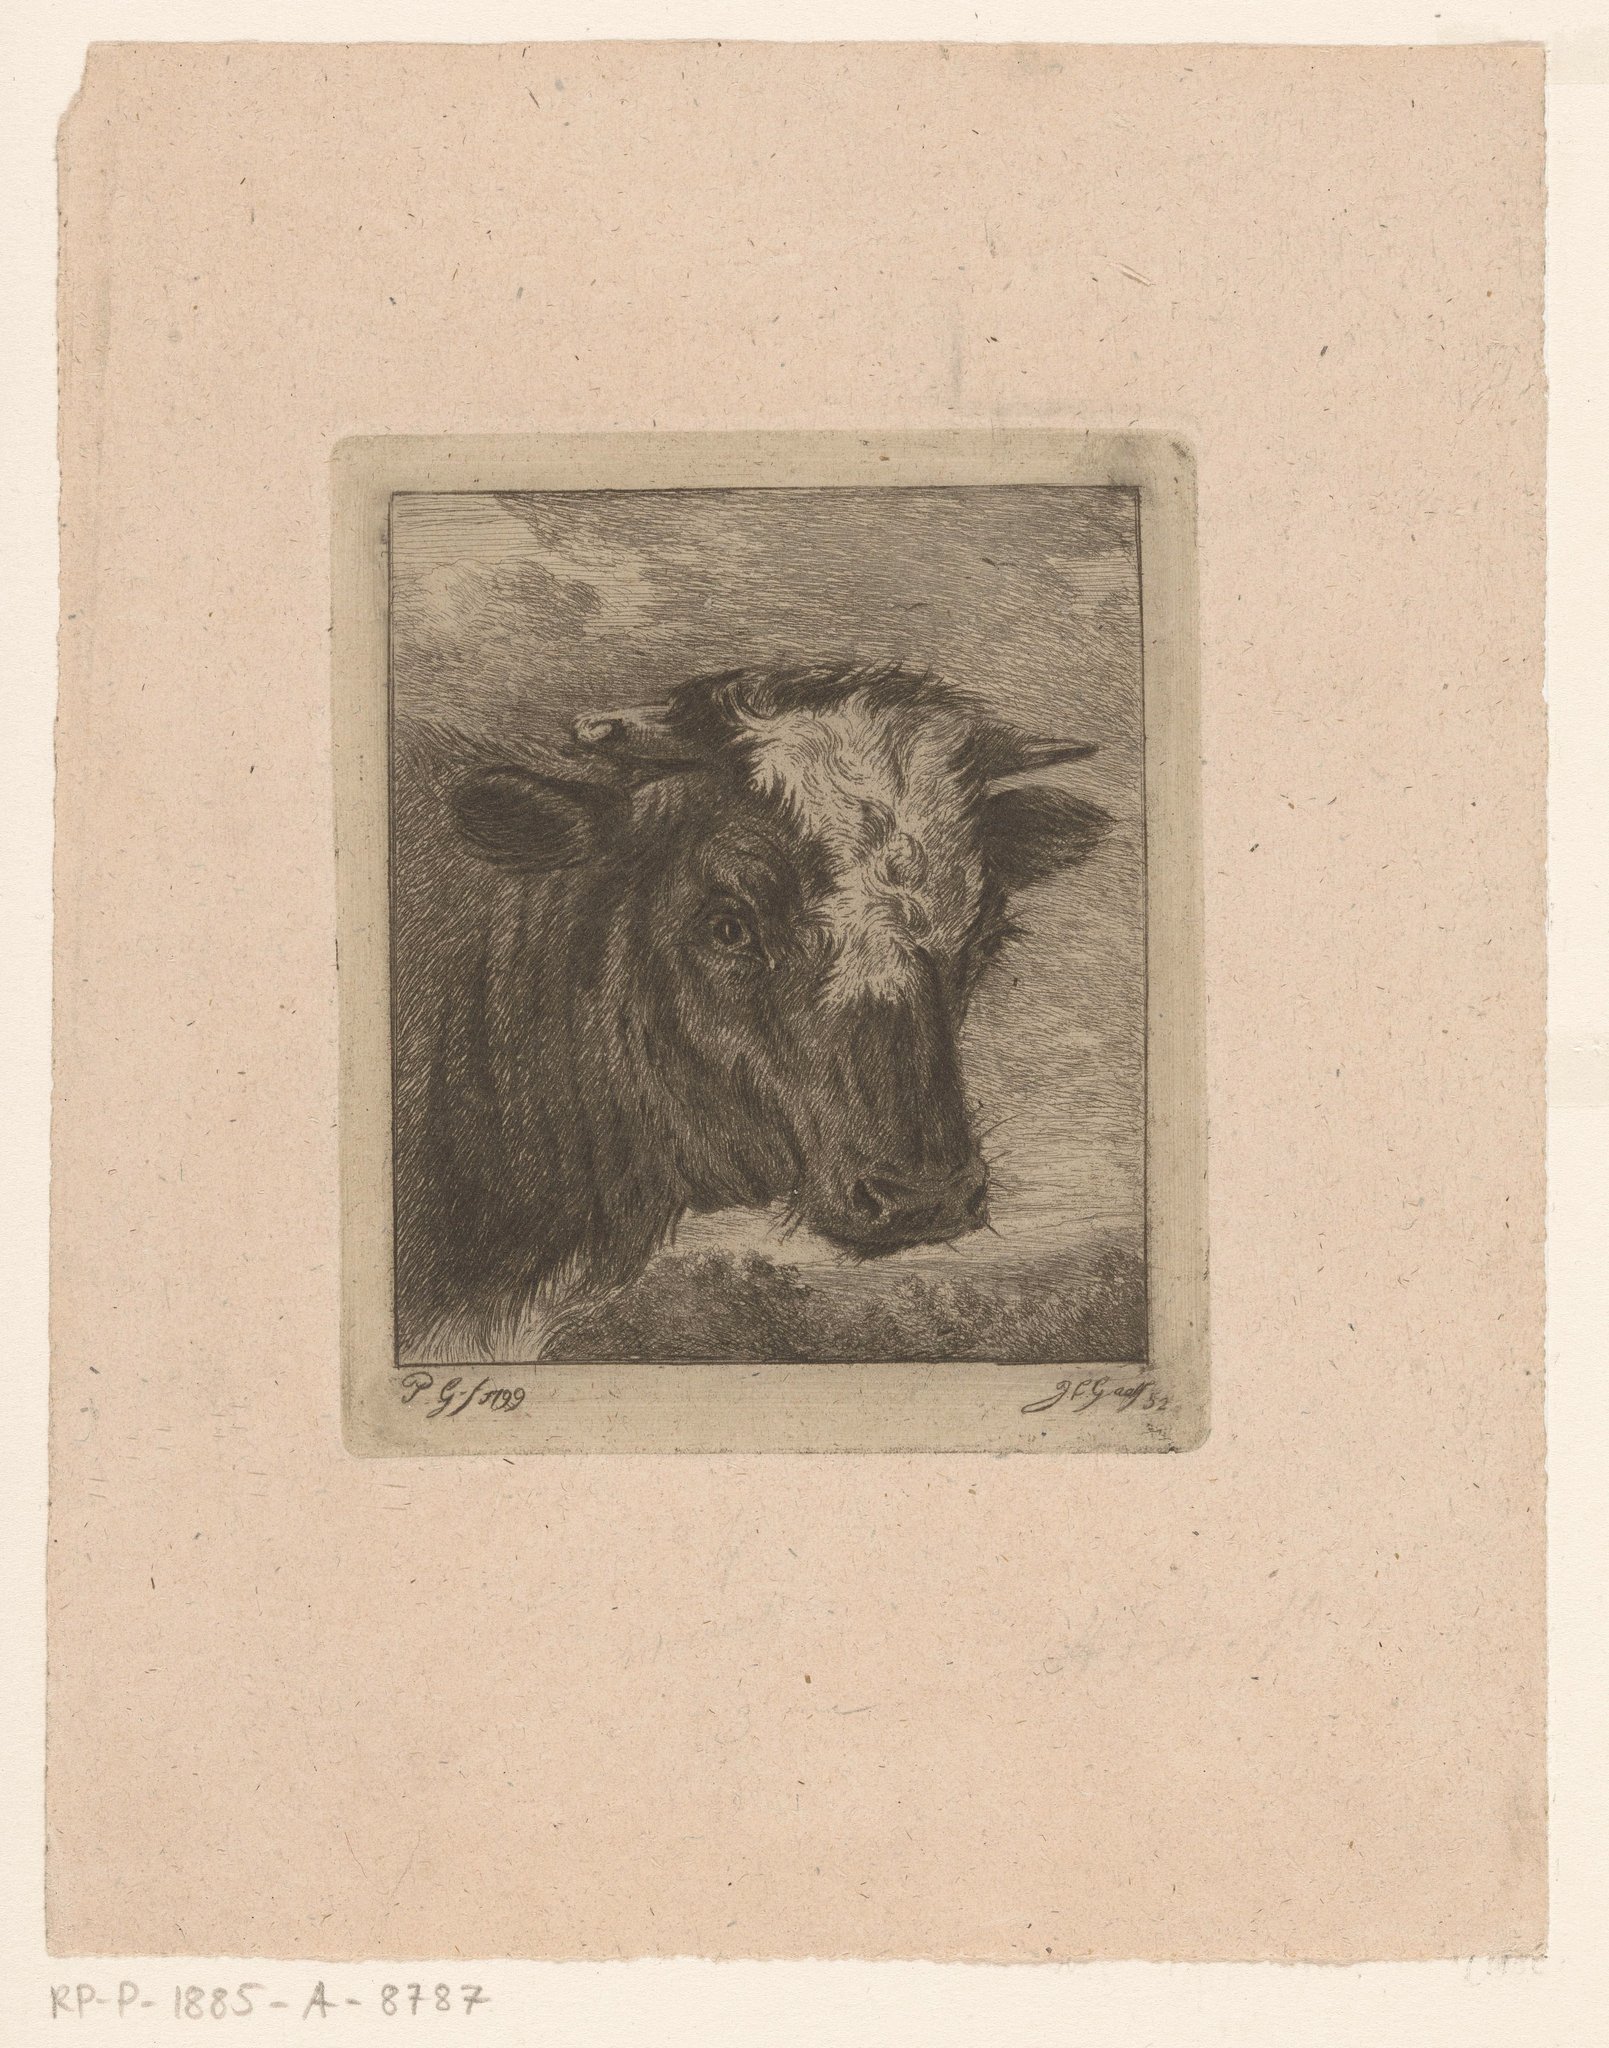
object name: print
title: Kop van een koe met witte kol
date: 1852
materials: paper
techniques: etching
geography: the hague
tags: cow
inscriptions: collector's mark: Lugt 2228